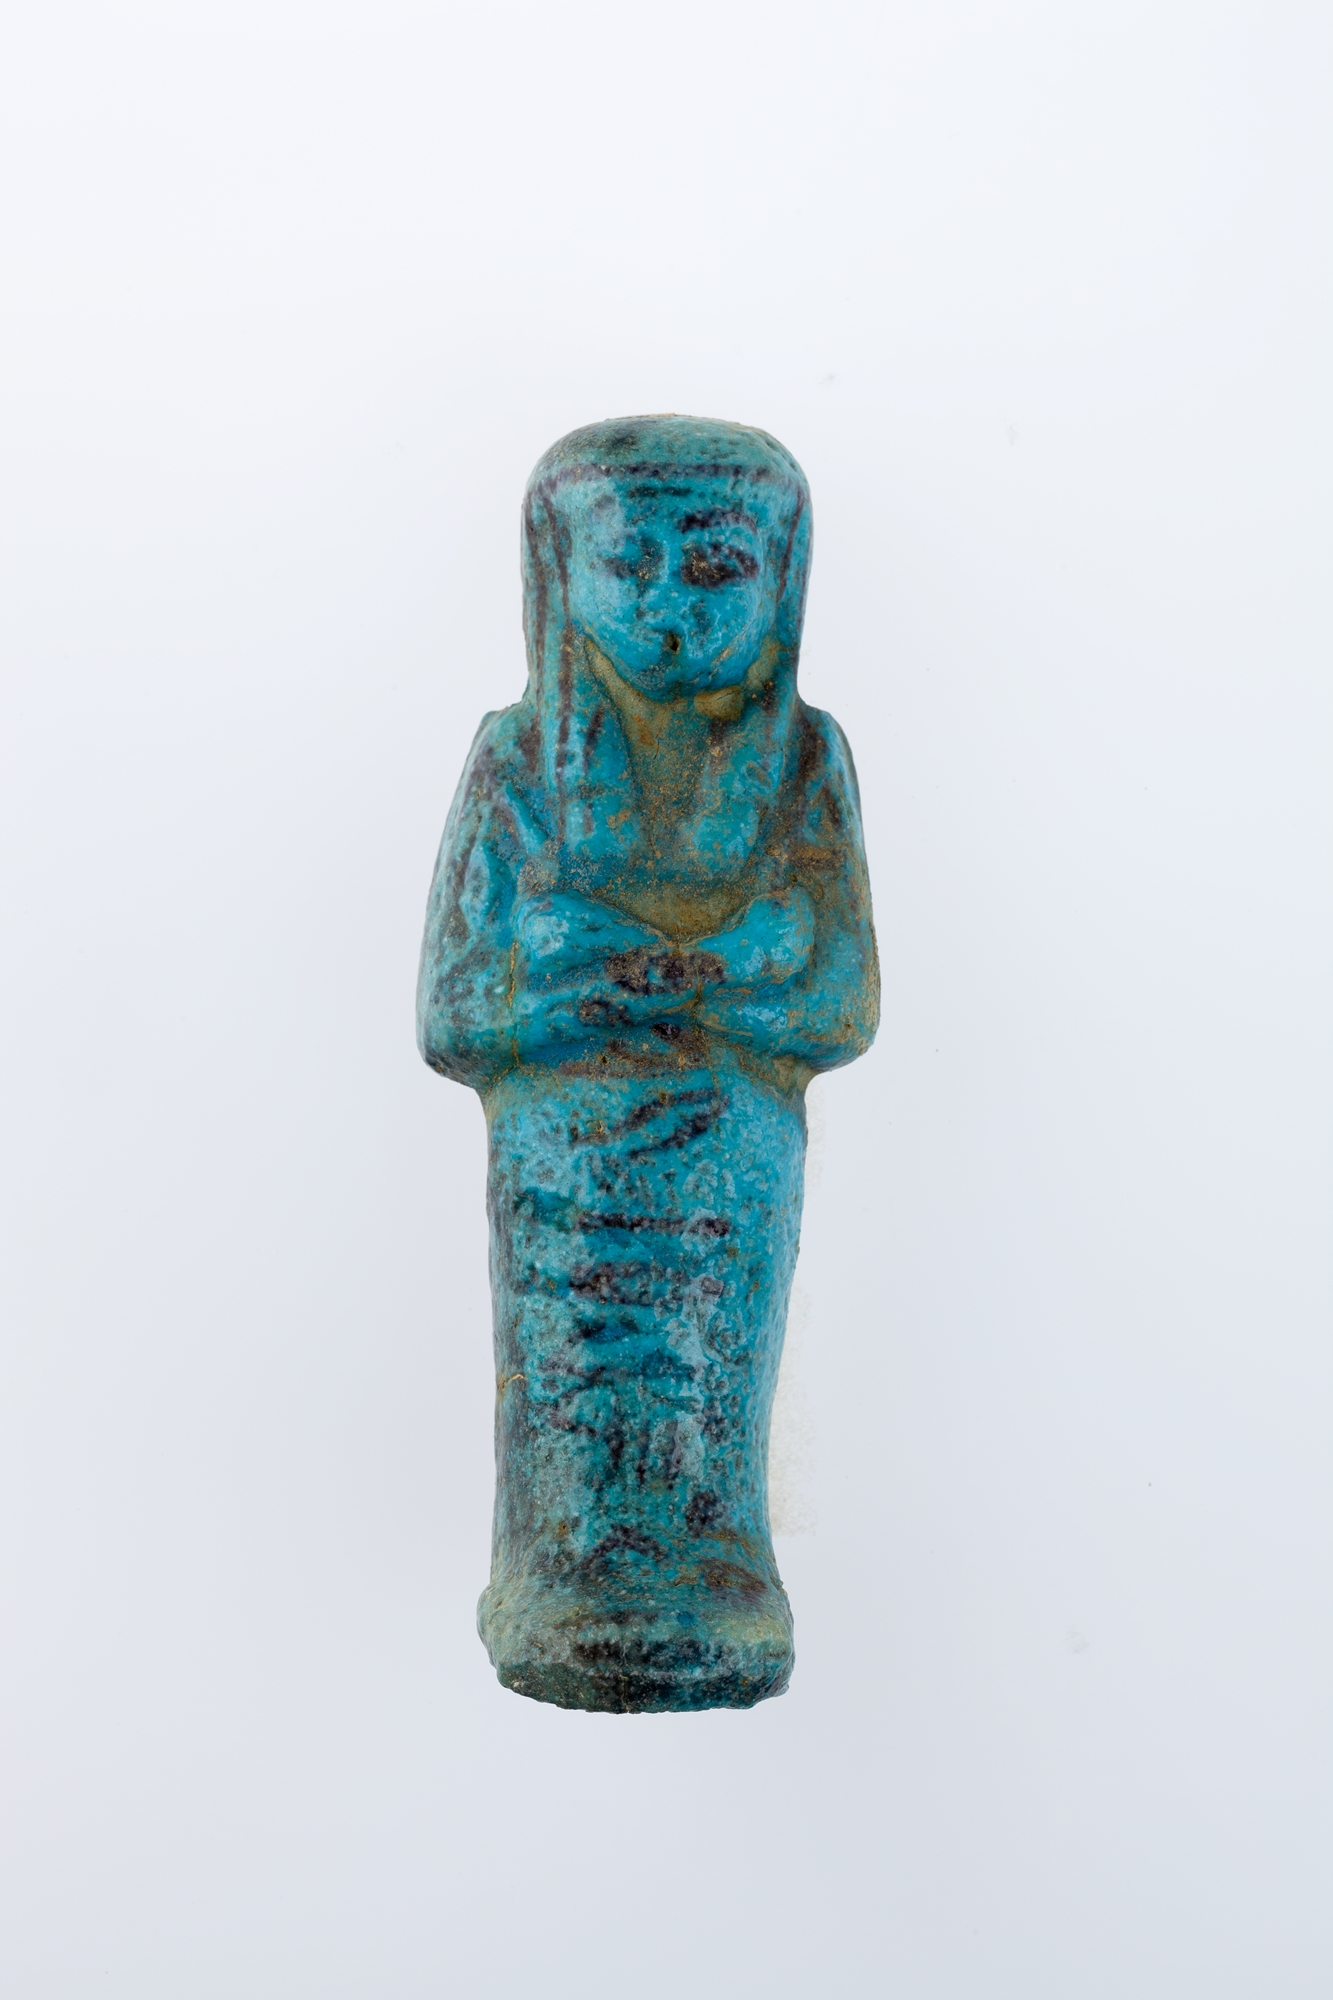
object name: shabti, henettawy c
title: Worker Shabti of Henettawy (C), Daughter of Isetemkheb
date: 990-970 BCE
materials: faience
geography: egypt